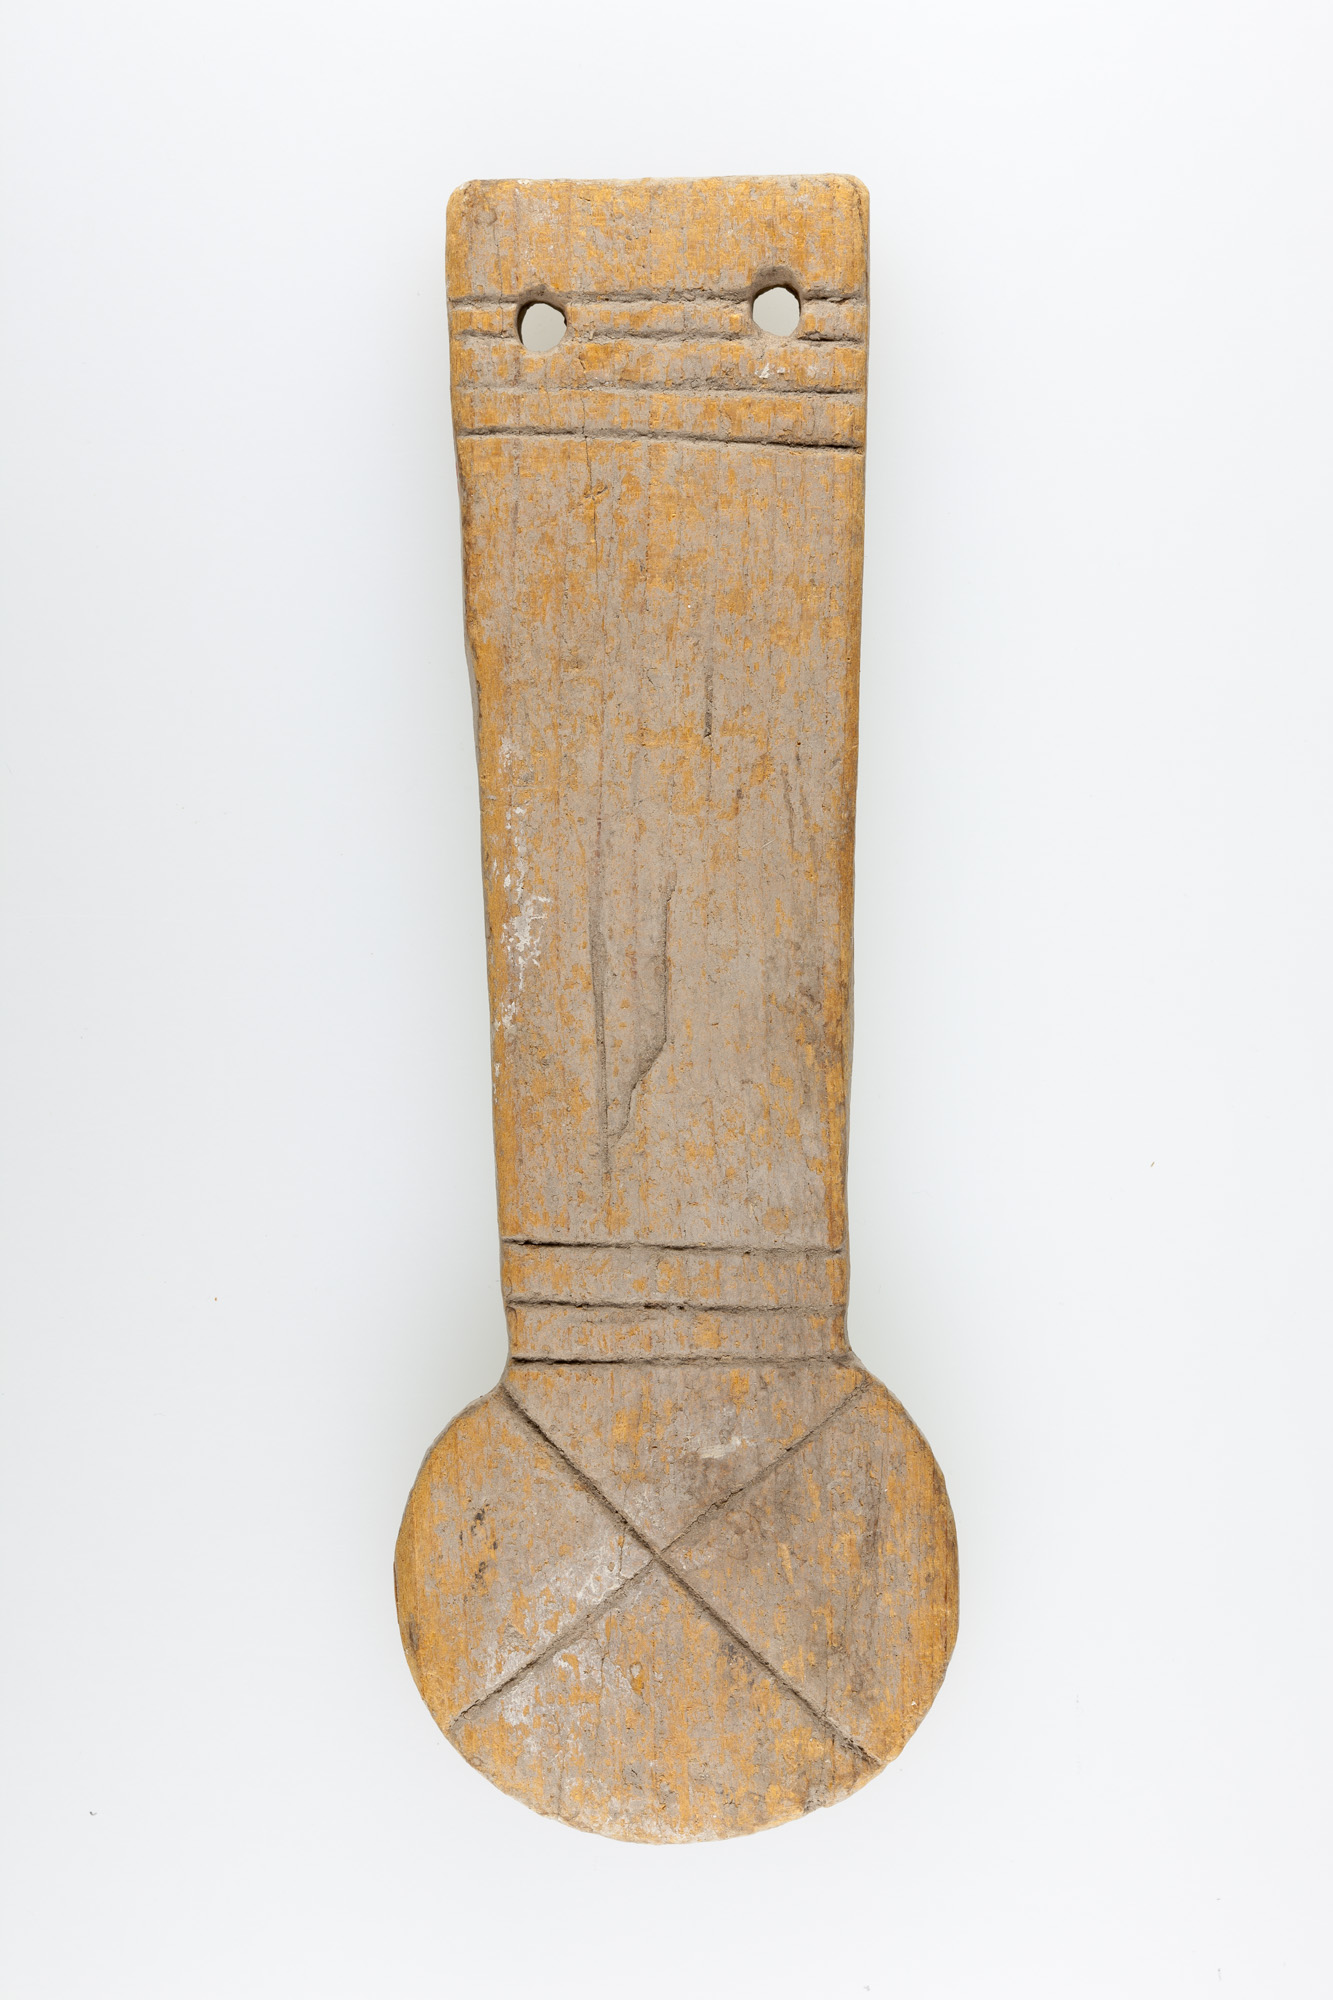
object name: menat fragment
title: Votive menat fragment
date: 1479-1458 BCE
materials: wood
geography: egypt